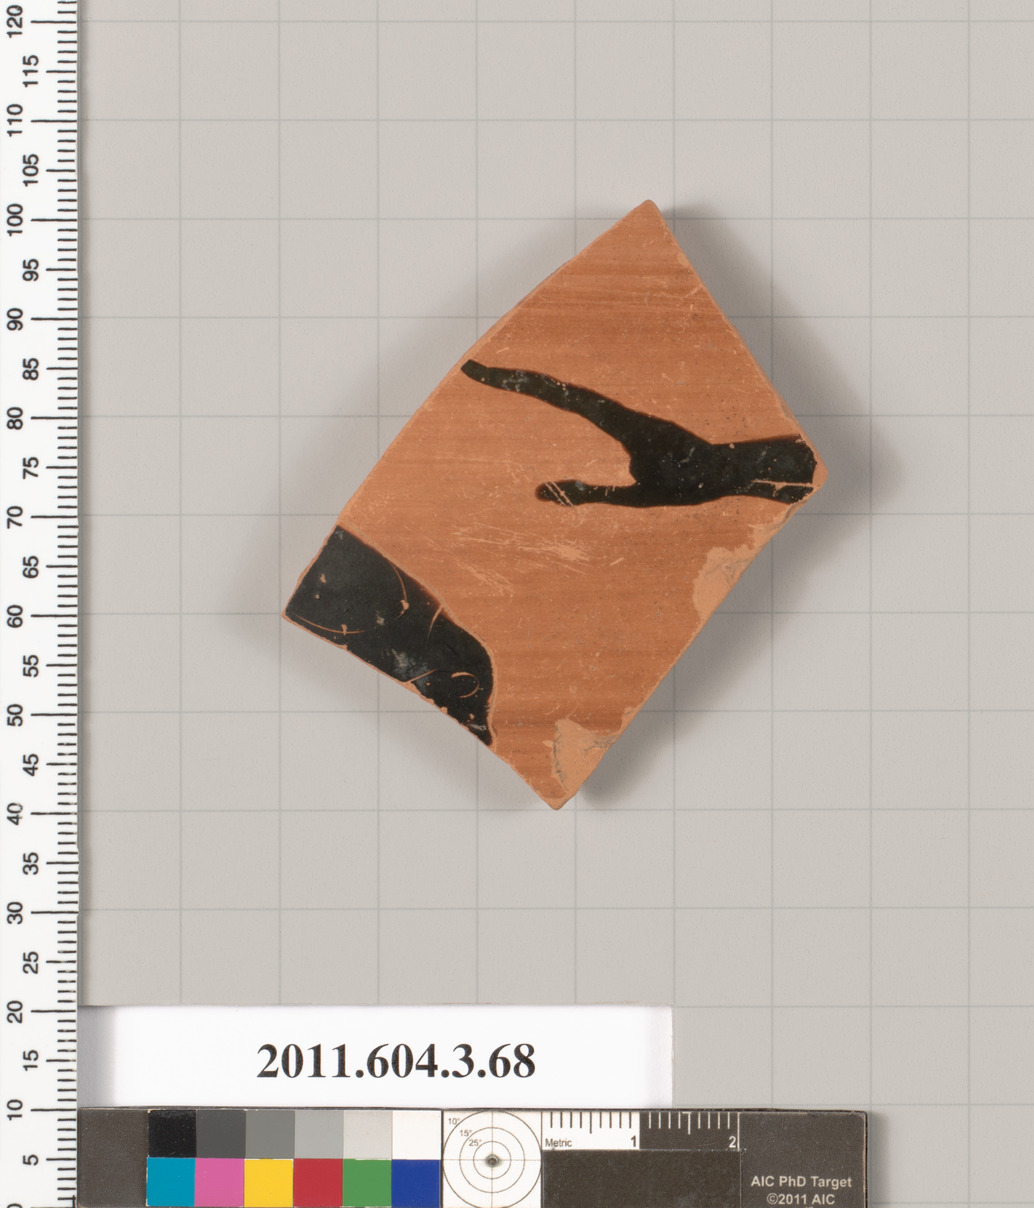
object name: amphora fragment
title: Terracotta fragment of an amphora (jar)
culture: greek, attic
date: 530-520 BCE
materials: terracotta